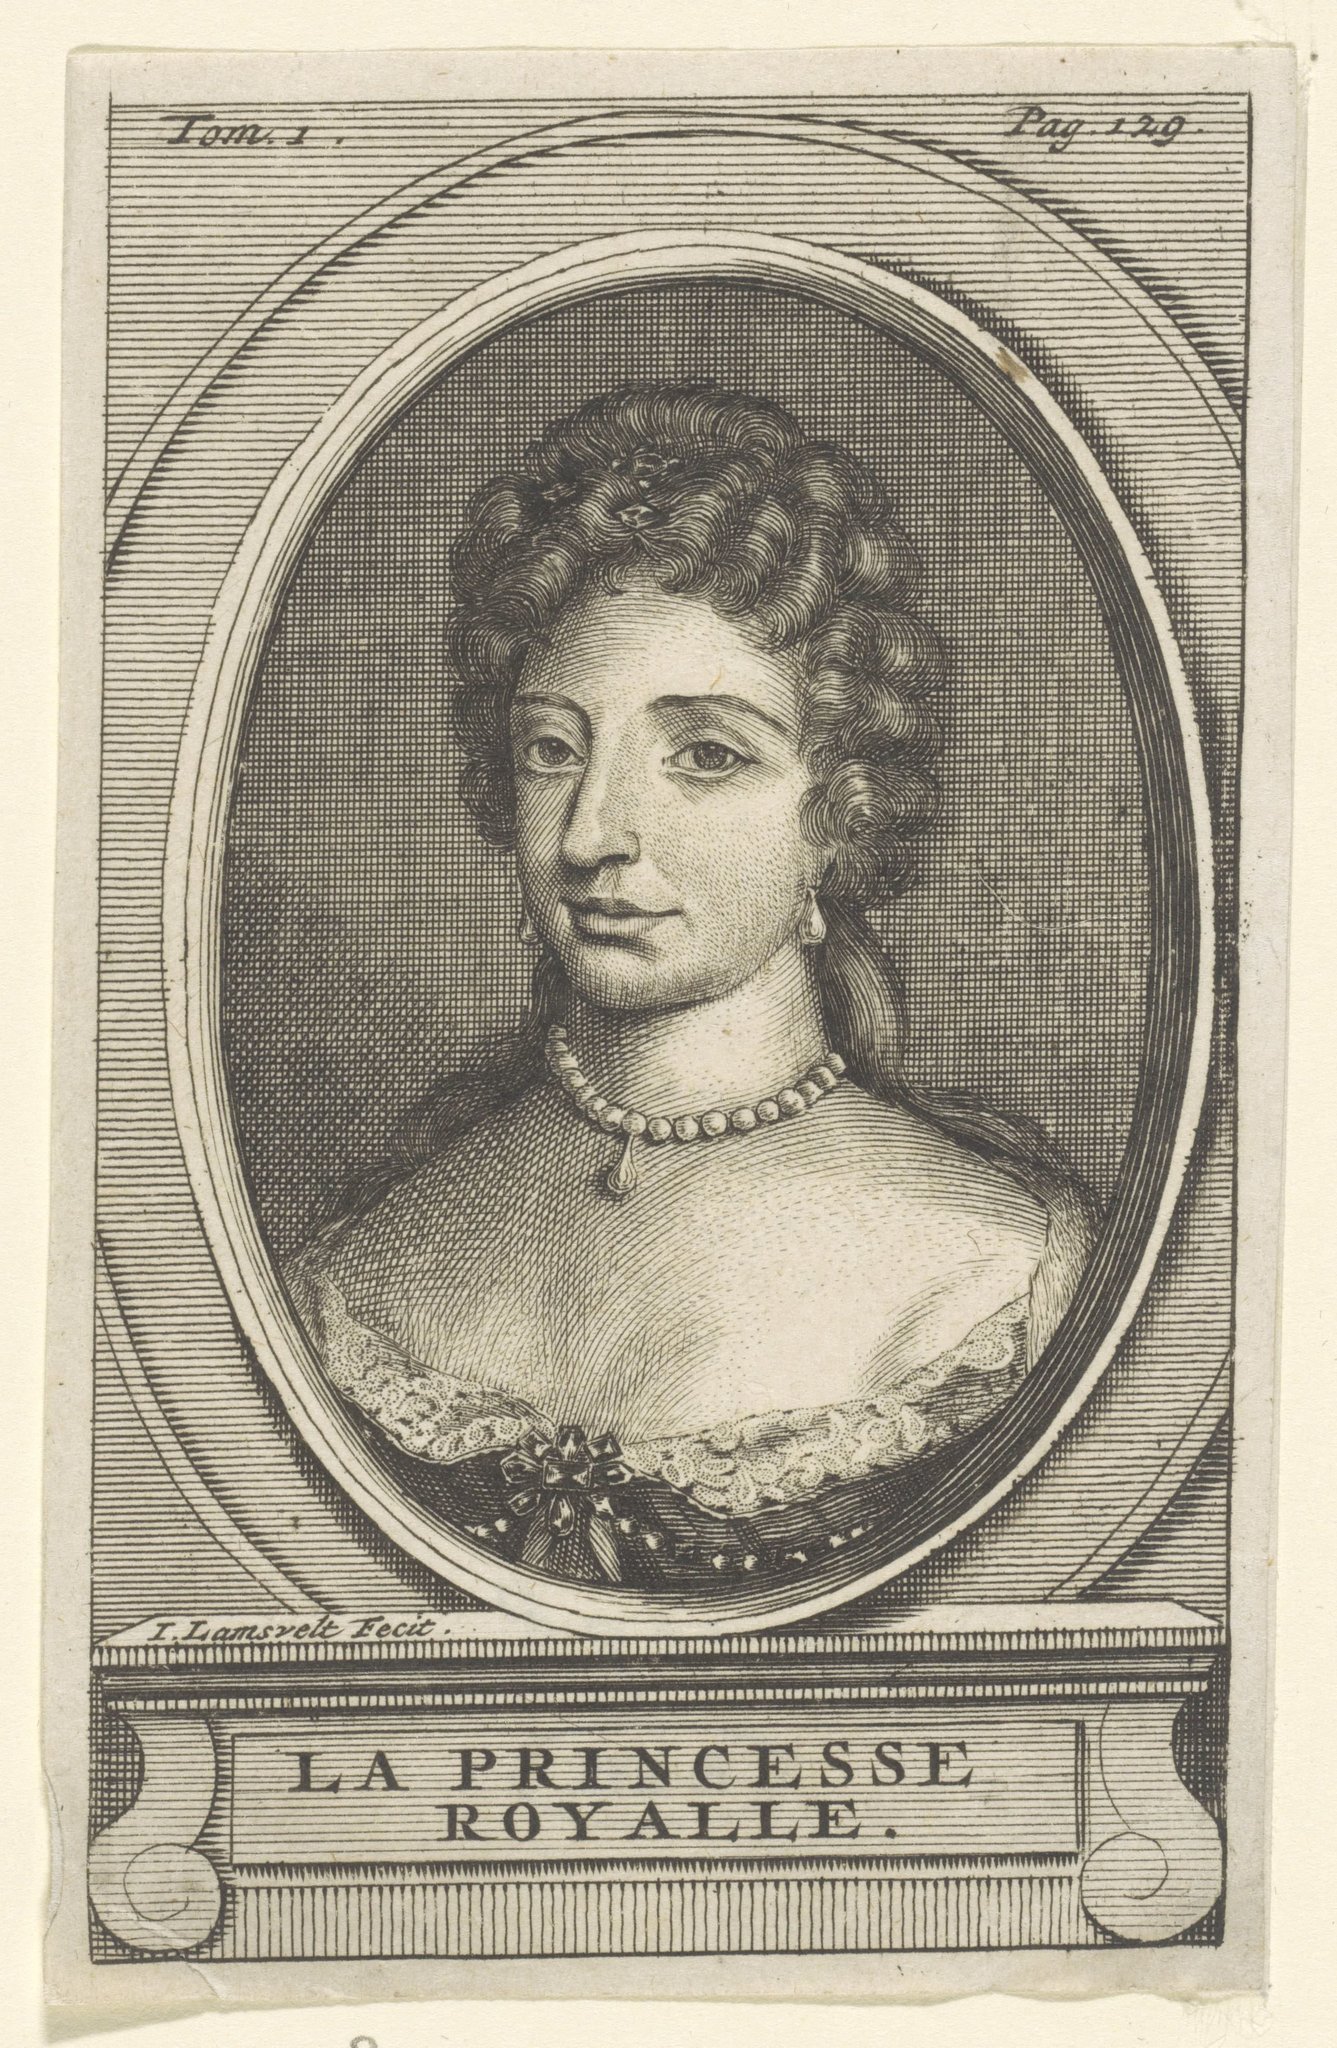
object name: print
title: Portret van Maria II Stuart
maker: jan lamsvelt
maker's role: print maker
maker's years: 1674-1743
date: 1696-1743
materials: paper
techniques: engraving, etching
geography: amsterdam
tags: london, maria ii stuart (koningin van engeland, schotland en ierland)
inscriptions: collector's mark: Lugt 2228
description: Portret van Maria II in een ovaal. Op een voetstuk haar titel in het Frans. Linksboven 'Tom. 1.'. Rechtsboven 'Pag. 129.'.